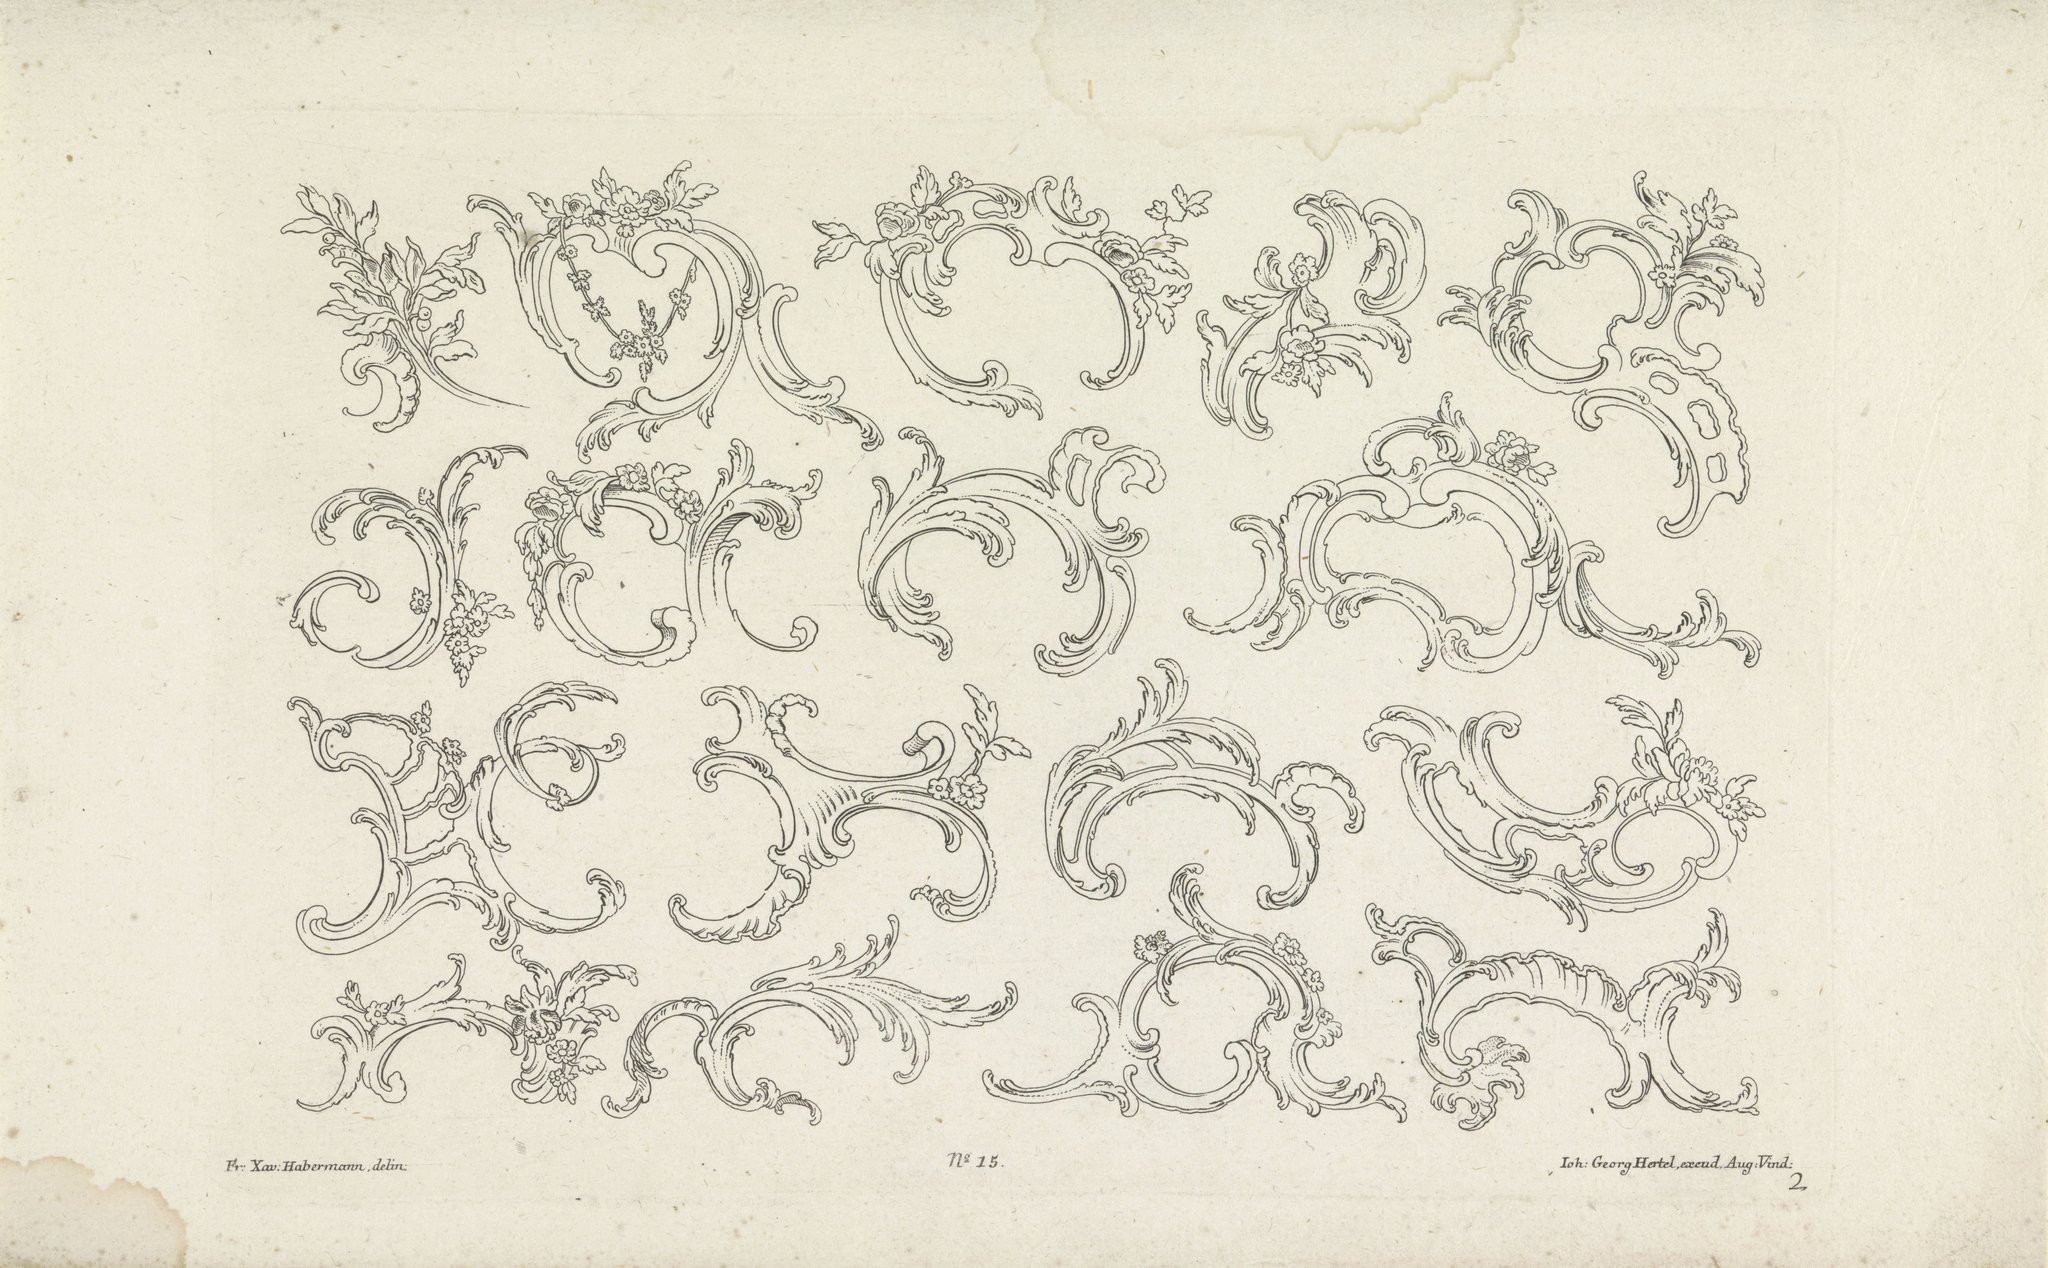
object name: ornament print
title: Rocailles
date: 1731-1775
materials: paper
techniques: etching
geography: augsburg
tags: rocaille ornament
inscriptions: collector's mark: Lugt 2760, collector's mark: Lugt 2228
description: Lijntekeningen van rocaille ornamenten. Uitgeversnummer 15.